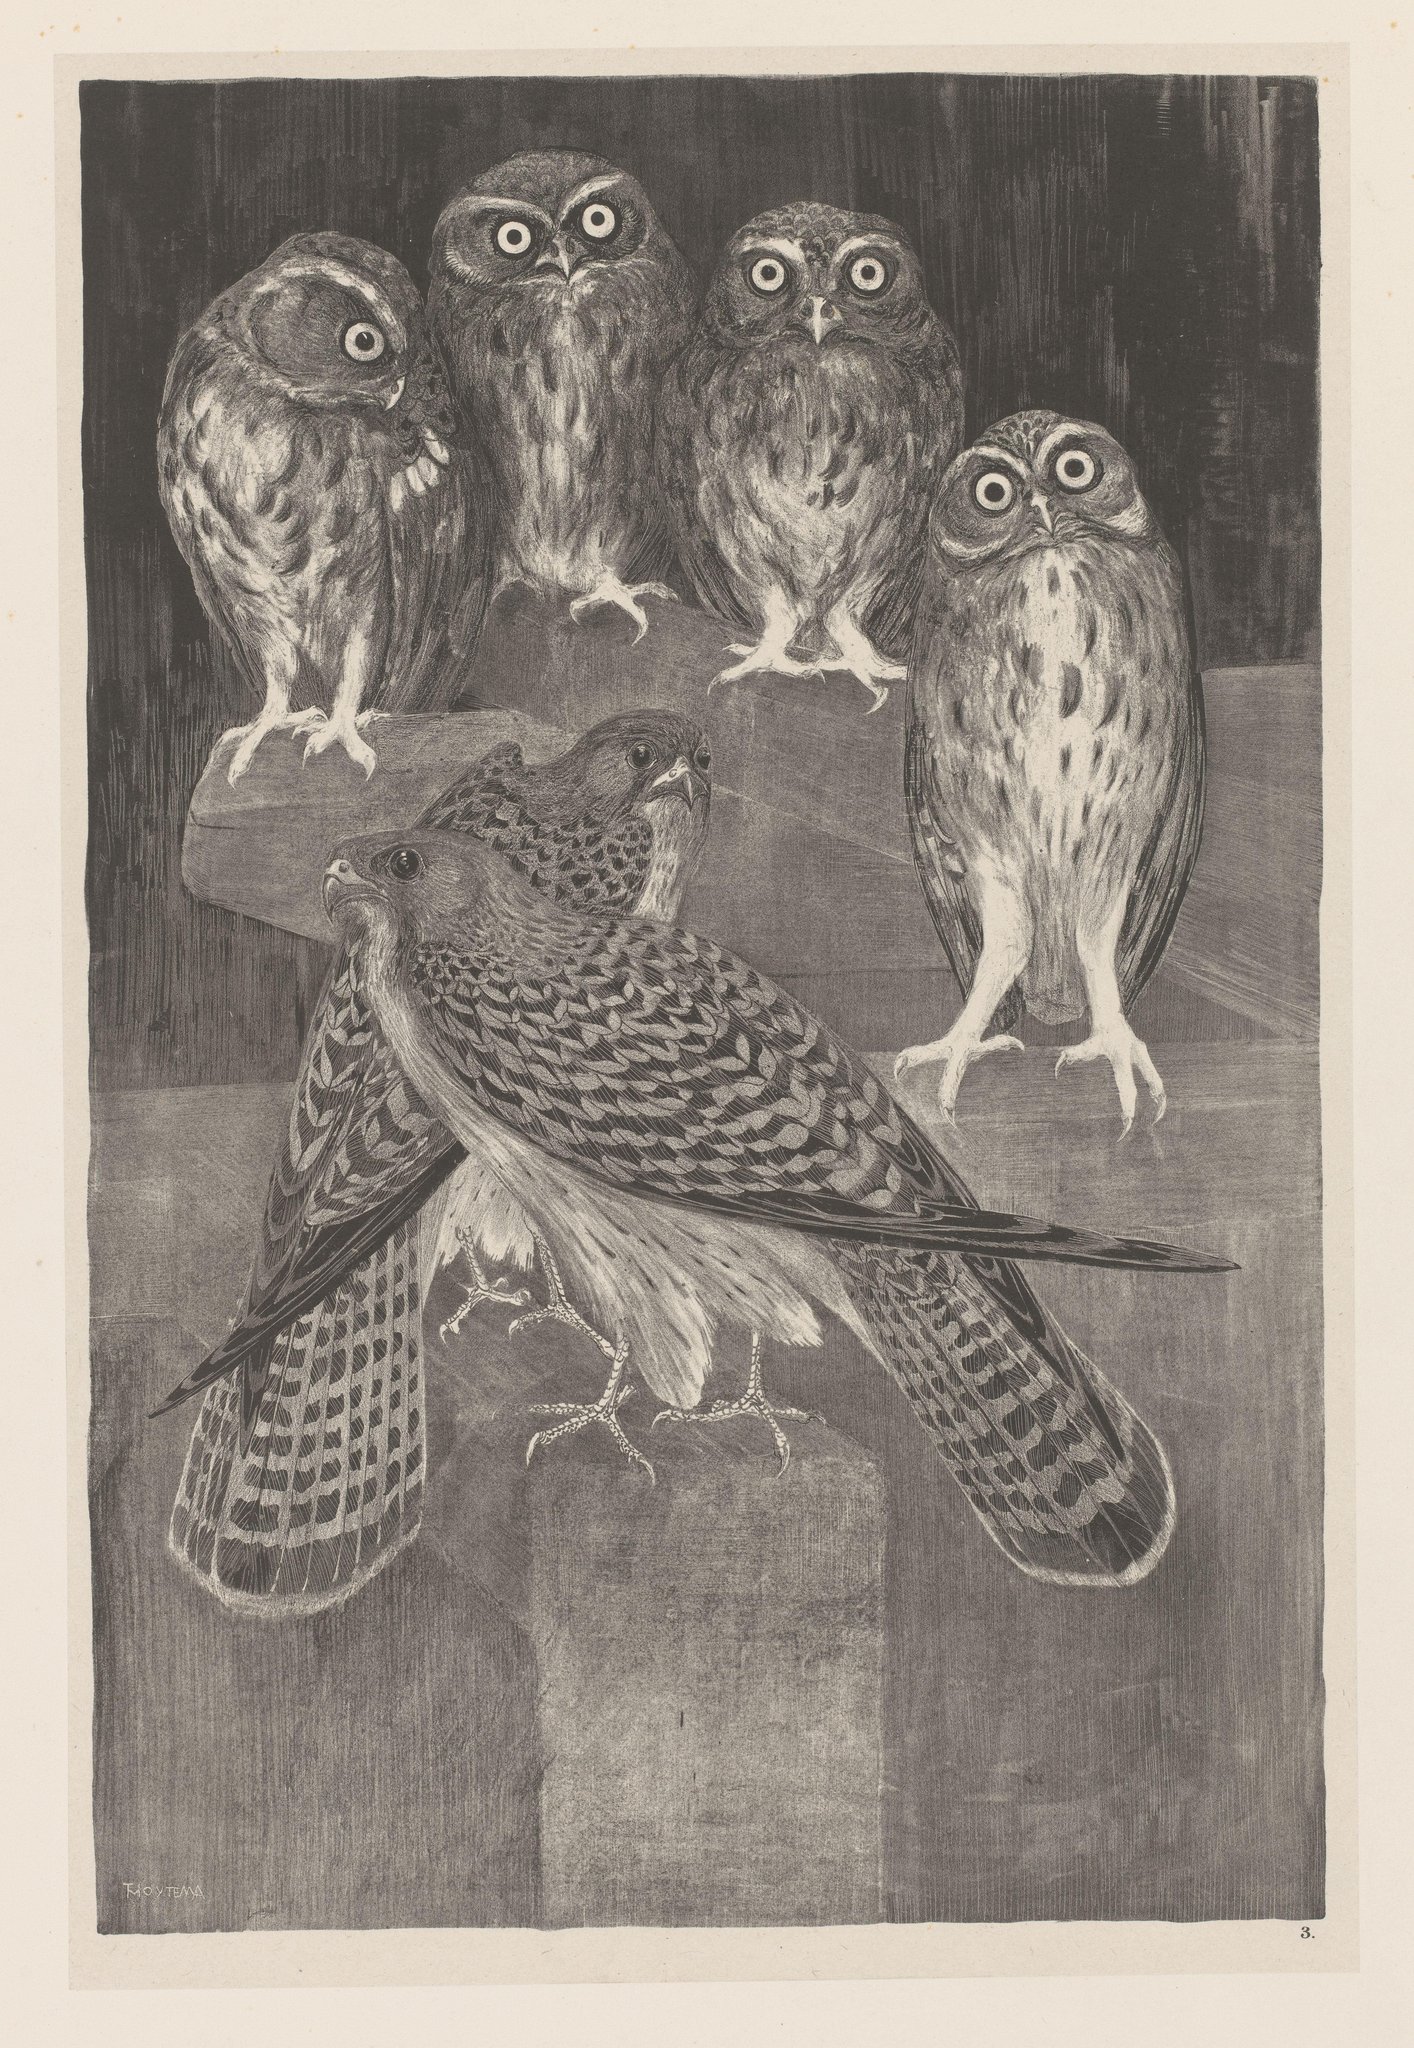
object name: print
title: Vier steenuilen en twee torenvalken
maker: theo van hoytema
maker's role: draughtsman, painter, print maker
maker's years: 1863-1917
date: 1898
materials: paper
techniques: lithograph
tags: predatory birds: falcon, owls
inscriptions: number: ‘3.’, collector's mark: Lugt 2233